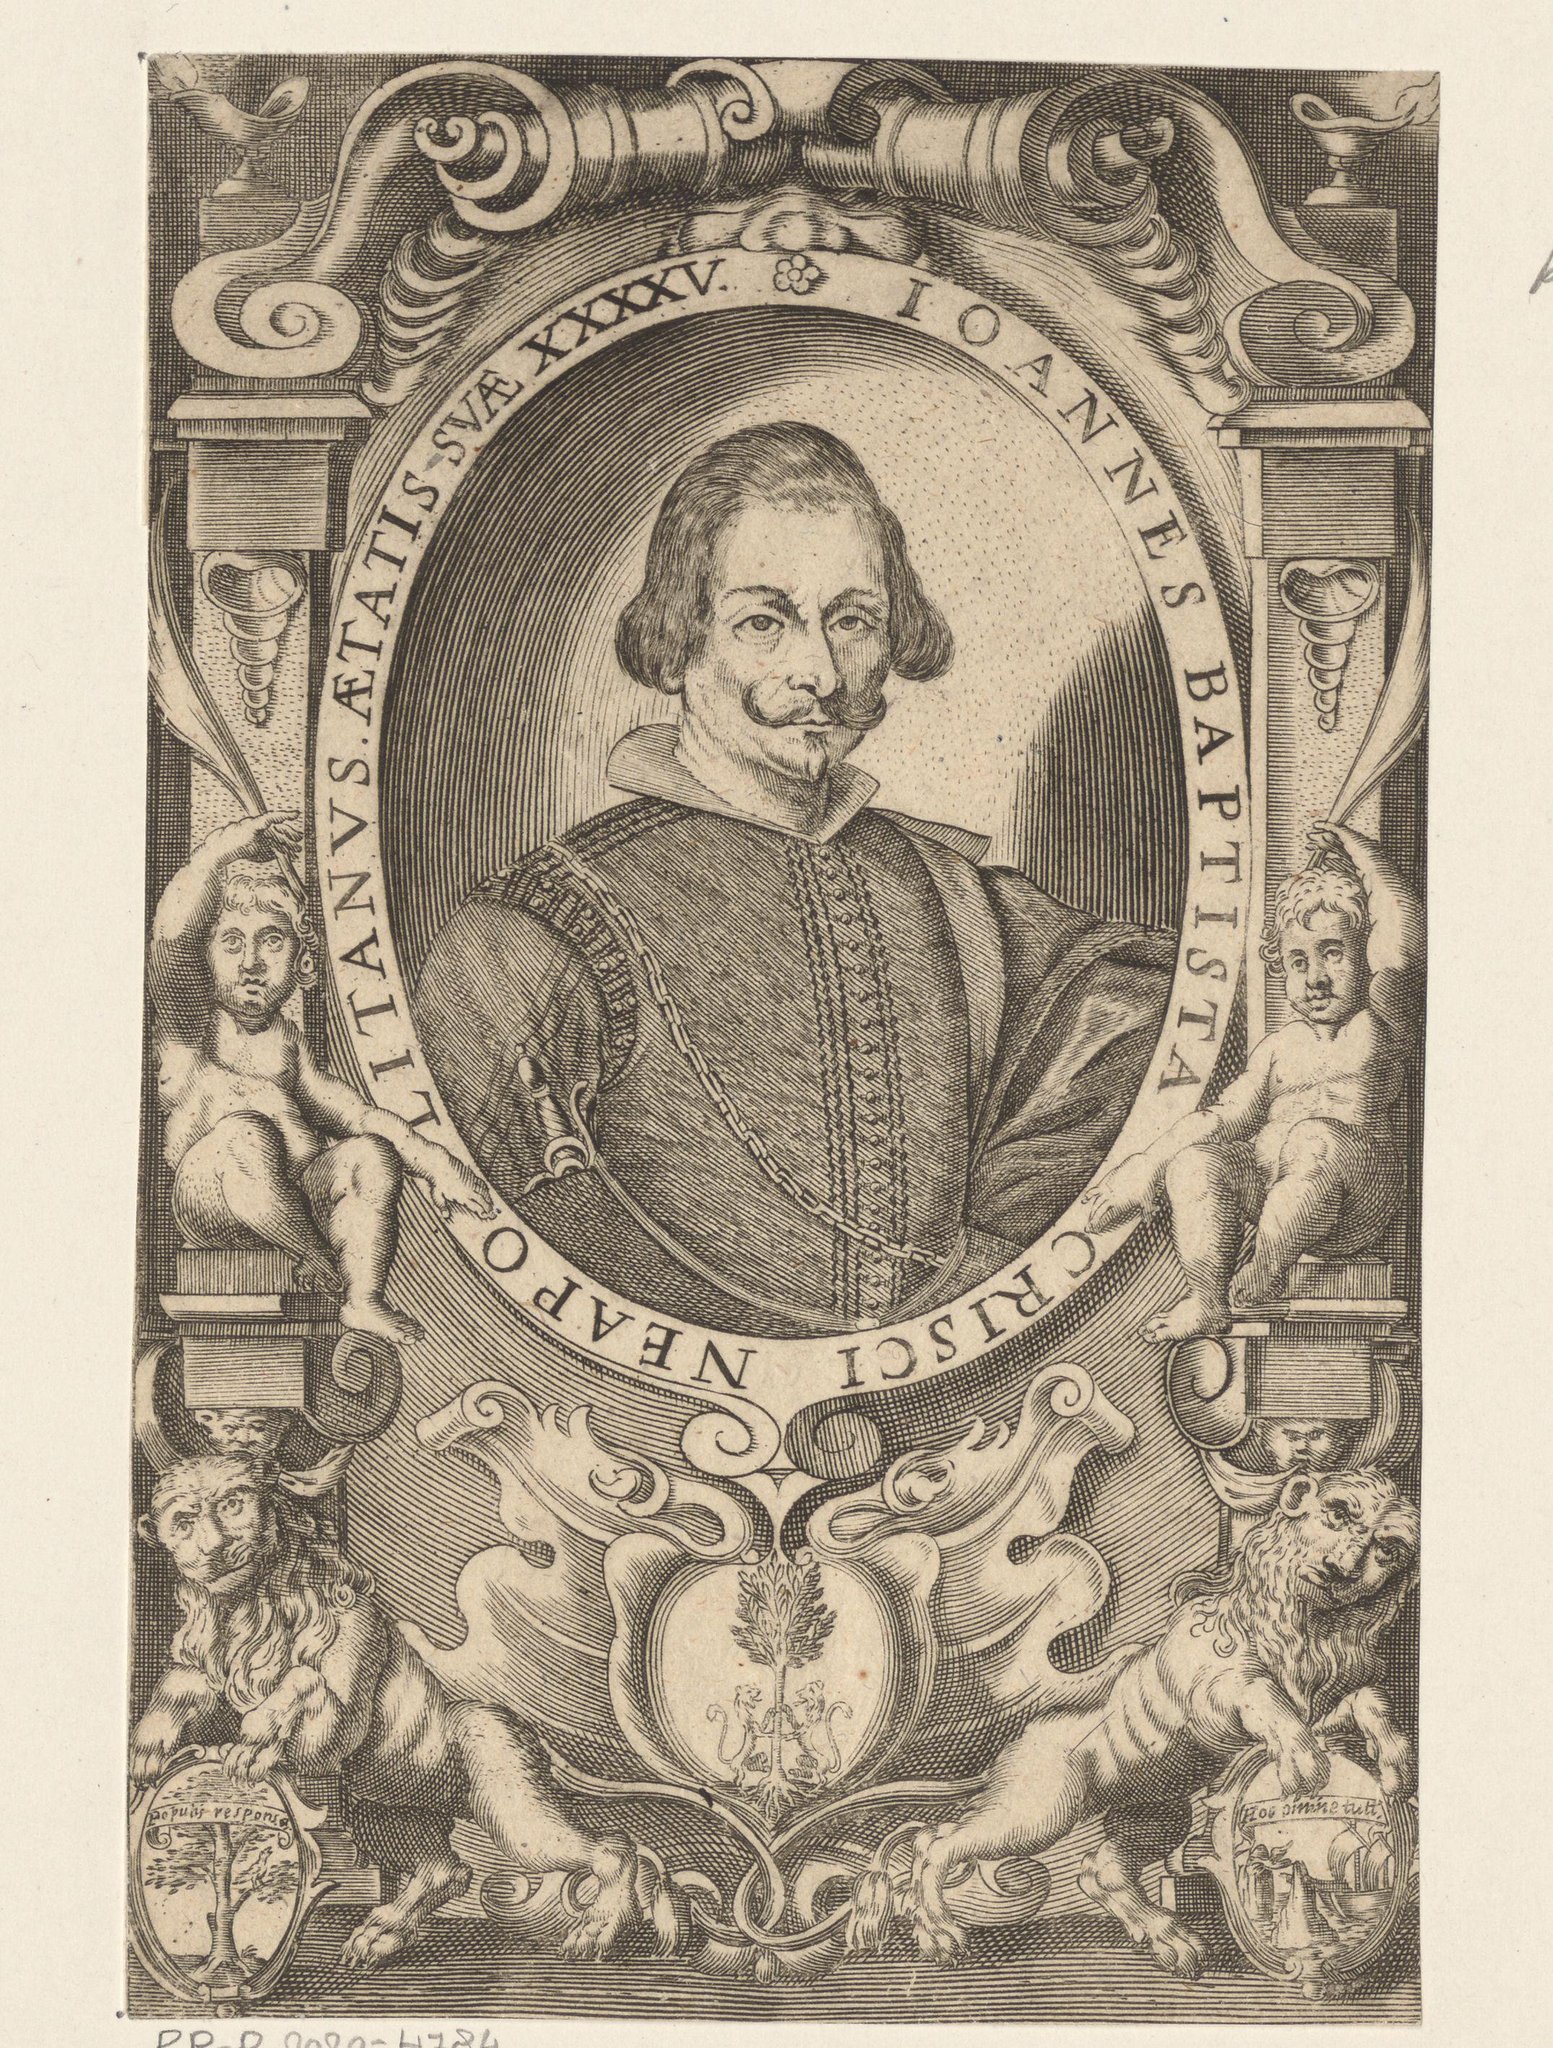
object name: print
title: Portret van Giovanni Battista Crisci op 45-jarige leeftijd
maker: Anonymous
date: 1634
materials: paper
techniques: engraving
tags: historical persons, beasts of prey, predatory animals: lion, armorial bearing, heraldry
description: Prent mogelijk uit: Crisci, Giovanni Battista. Lucerna de corteggiani oue in dialogo (...). Napels: s.n., 1634.